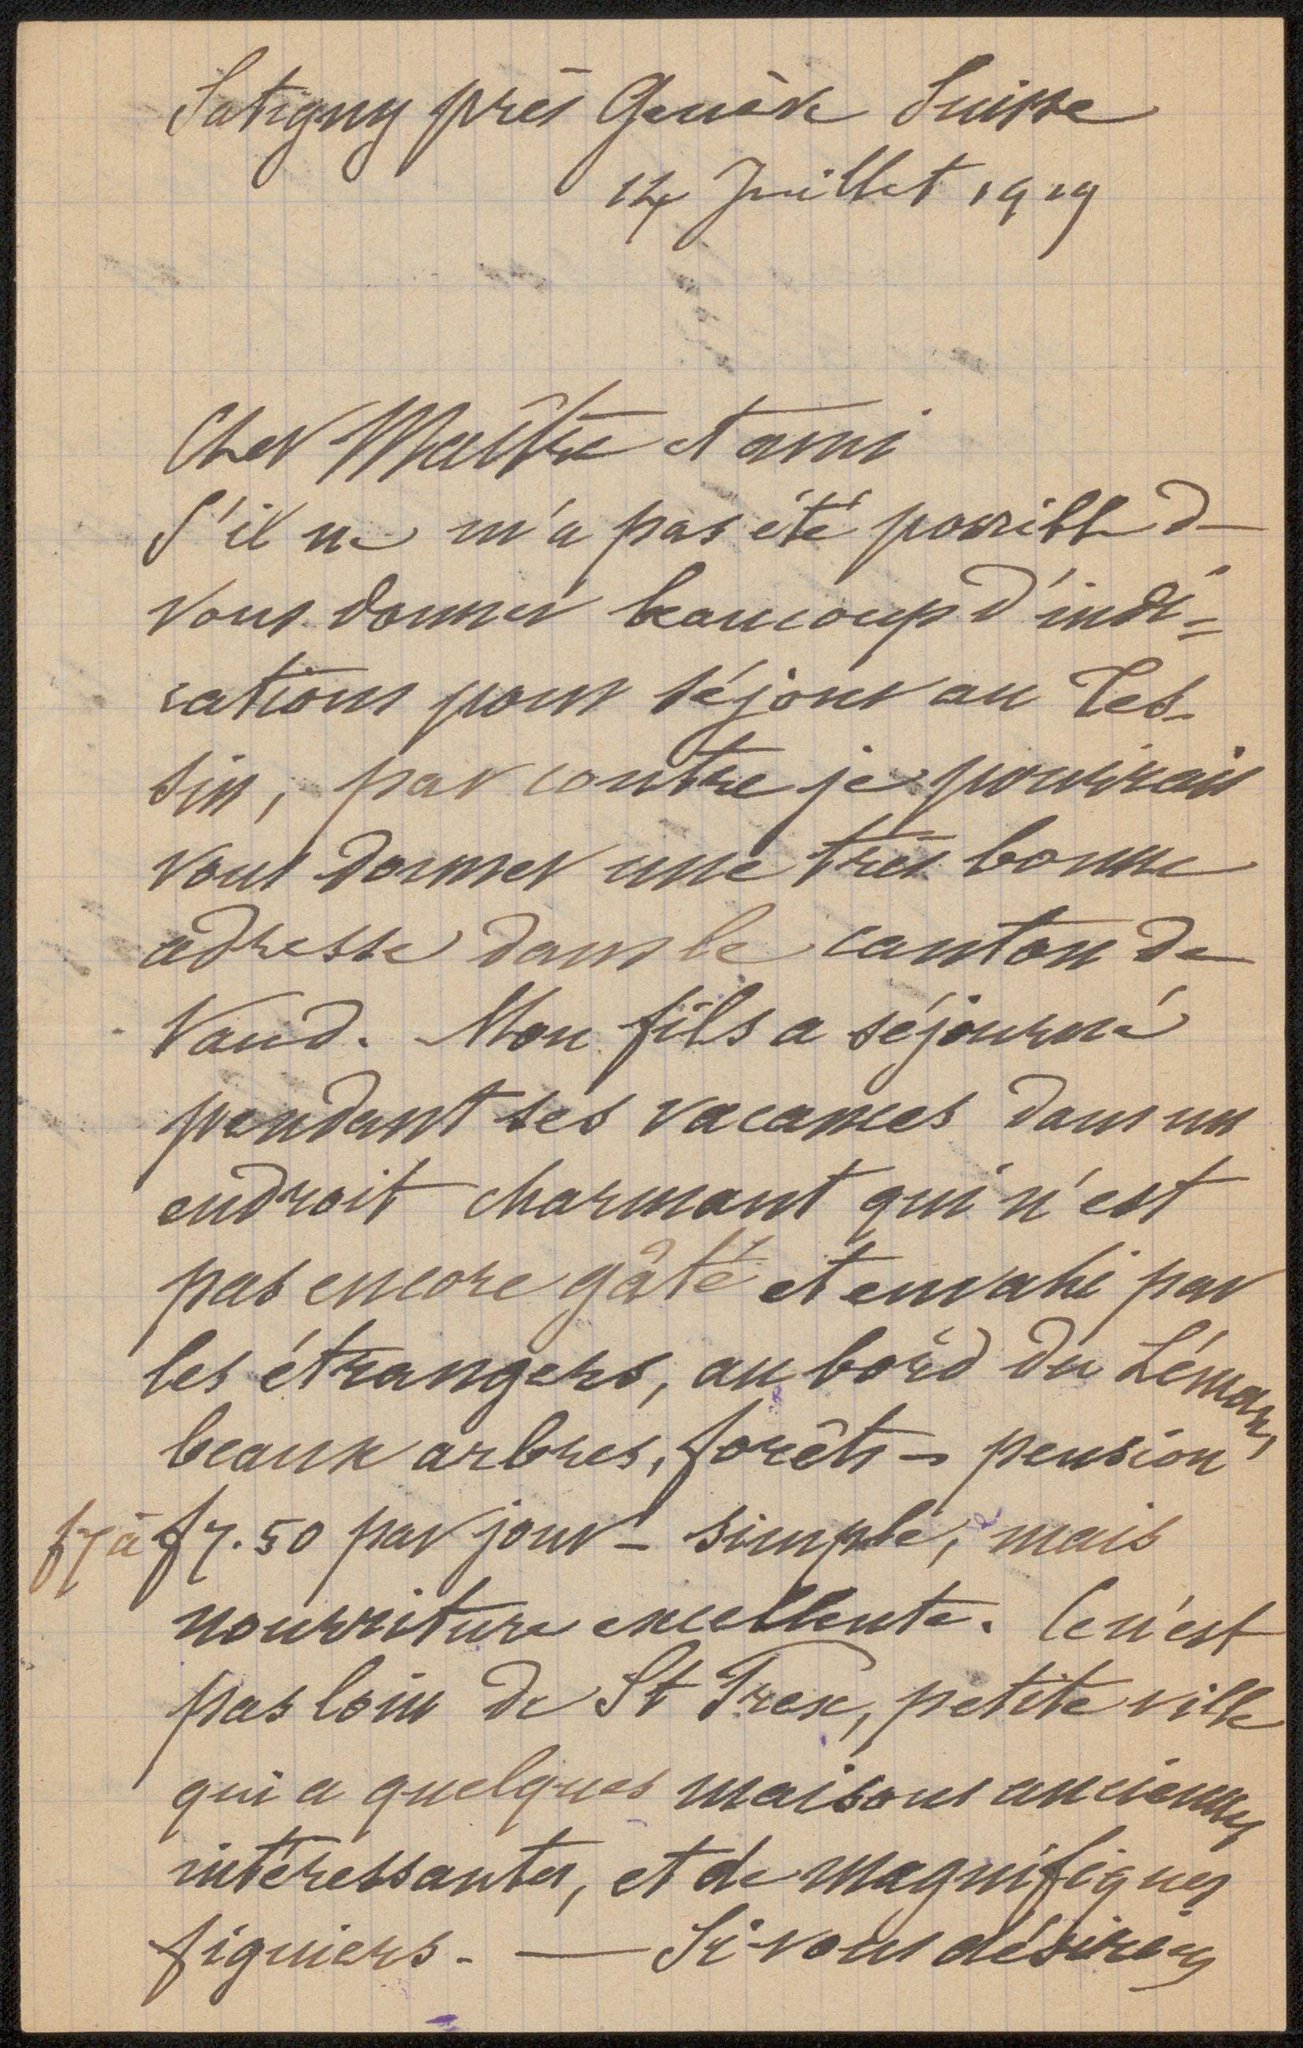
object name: letter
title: Brief aan Philip Zilcken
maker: alphonse stengelin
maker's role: painter, print maker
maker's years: 1852-1938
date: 1919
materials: ink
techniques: pen, writing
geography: satigny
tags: painter, draughtsman, philip zilcken, family life, travelling; tourism, netherlands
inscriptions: collector's mark: ‘RPK’